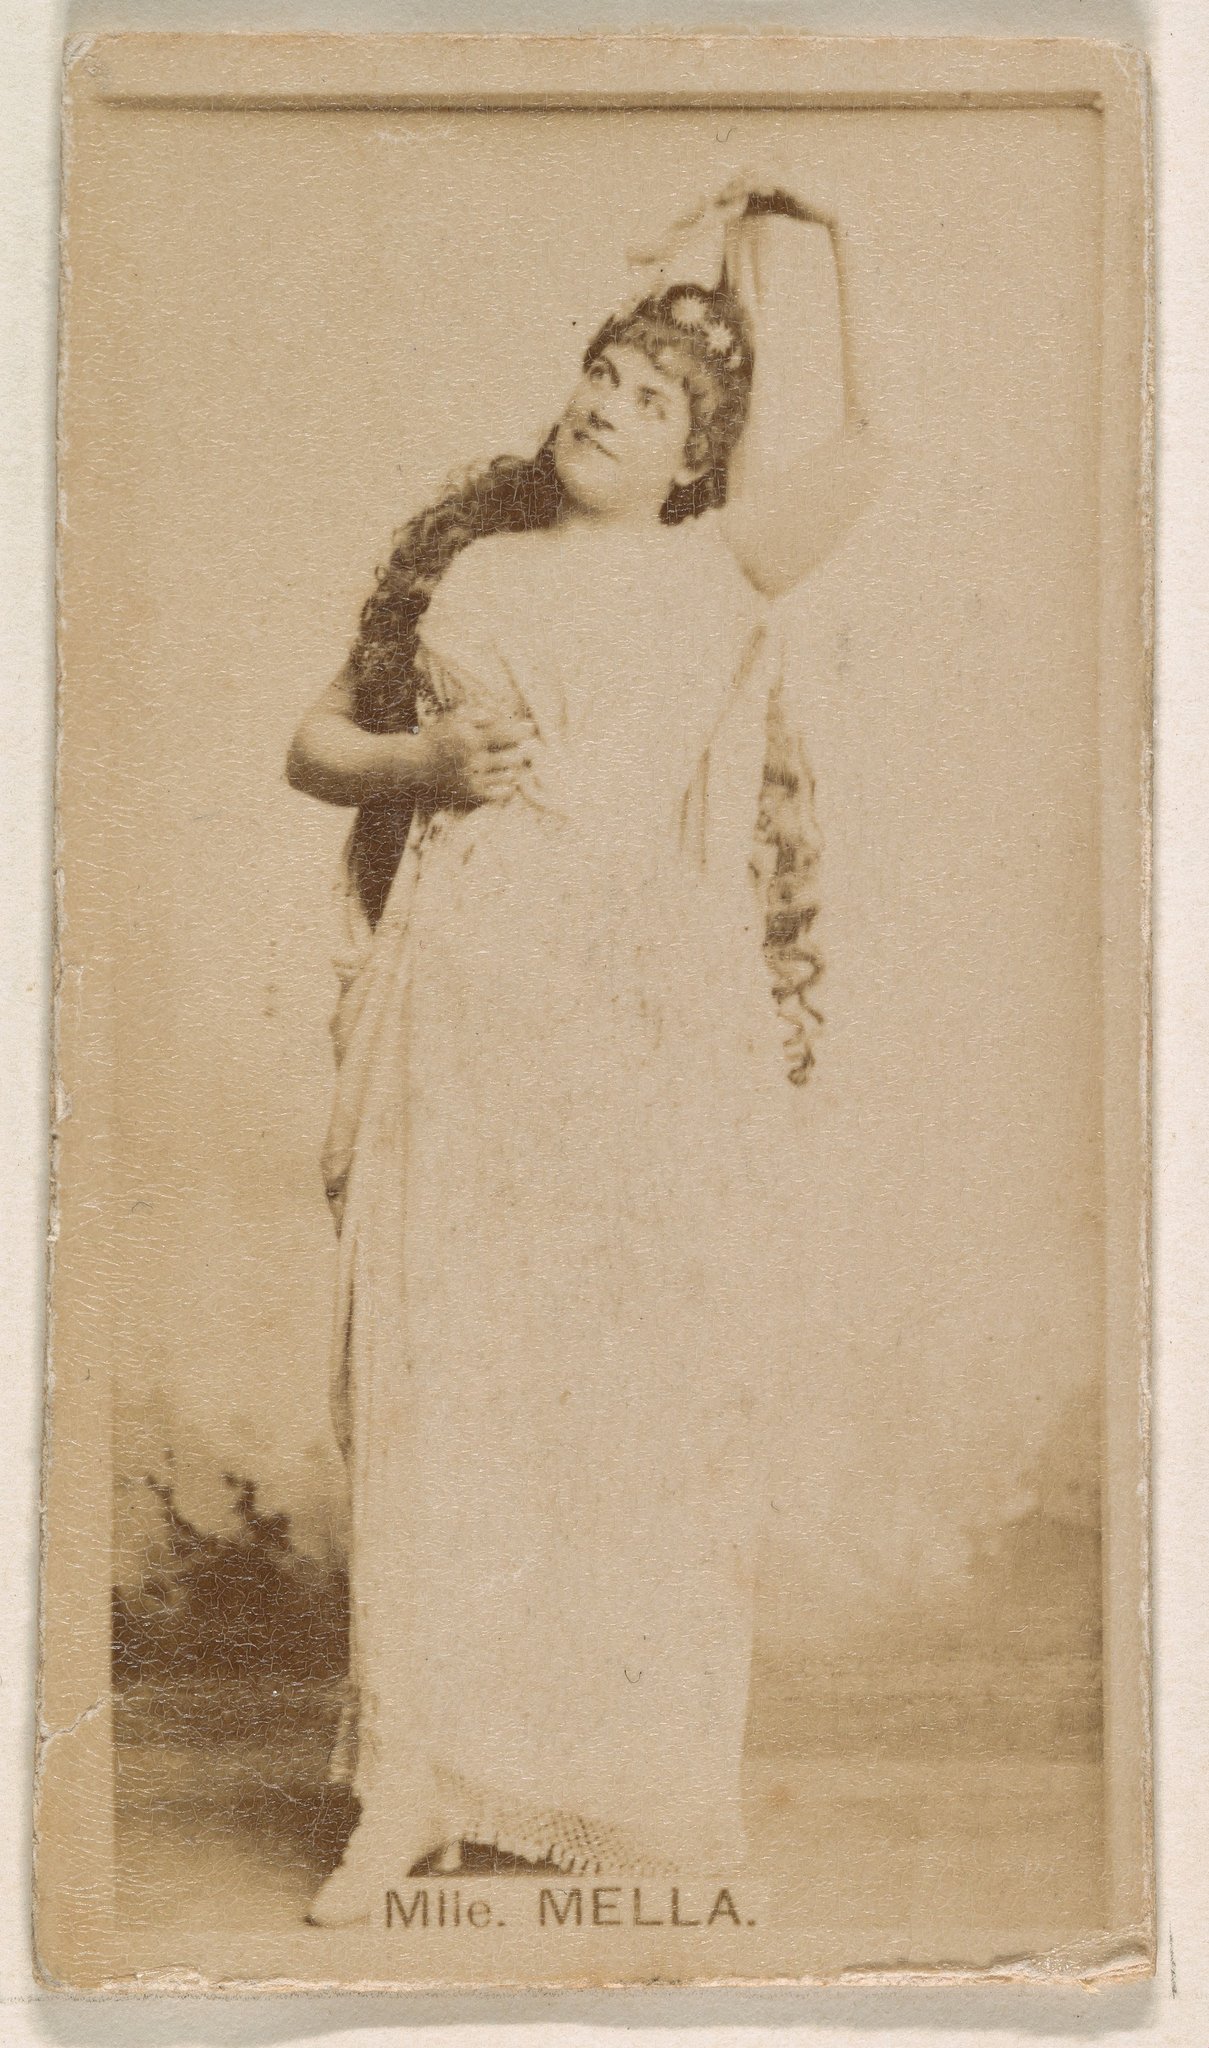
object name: photograph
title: Mlle. Mella, from the Actresses series (N245) issued by Kinney Brothers to promote Sweet Caporal Cigarettes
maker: kinney brothers tobacco company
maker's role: publisher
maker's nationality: american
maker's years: 1869-2011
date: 1890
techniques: albumen silver print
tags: portraits,women,actresses